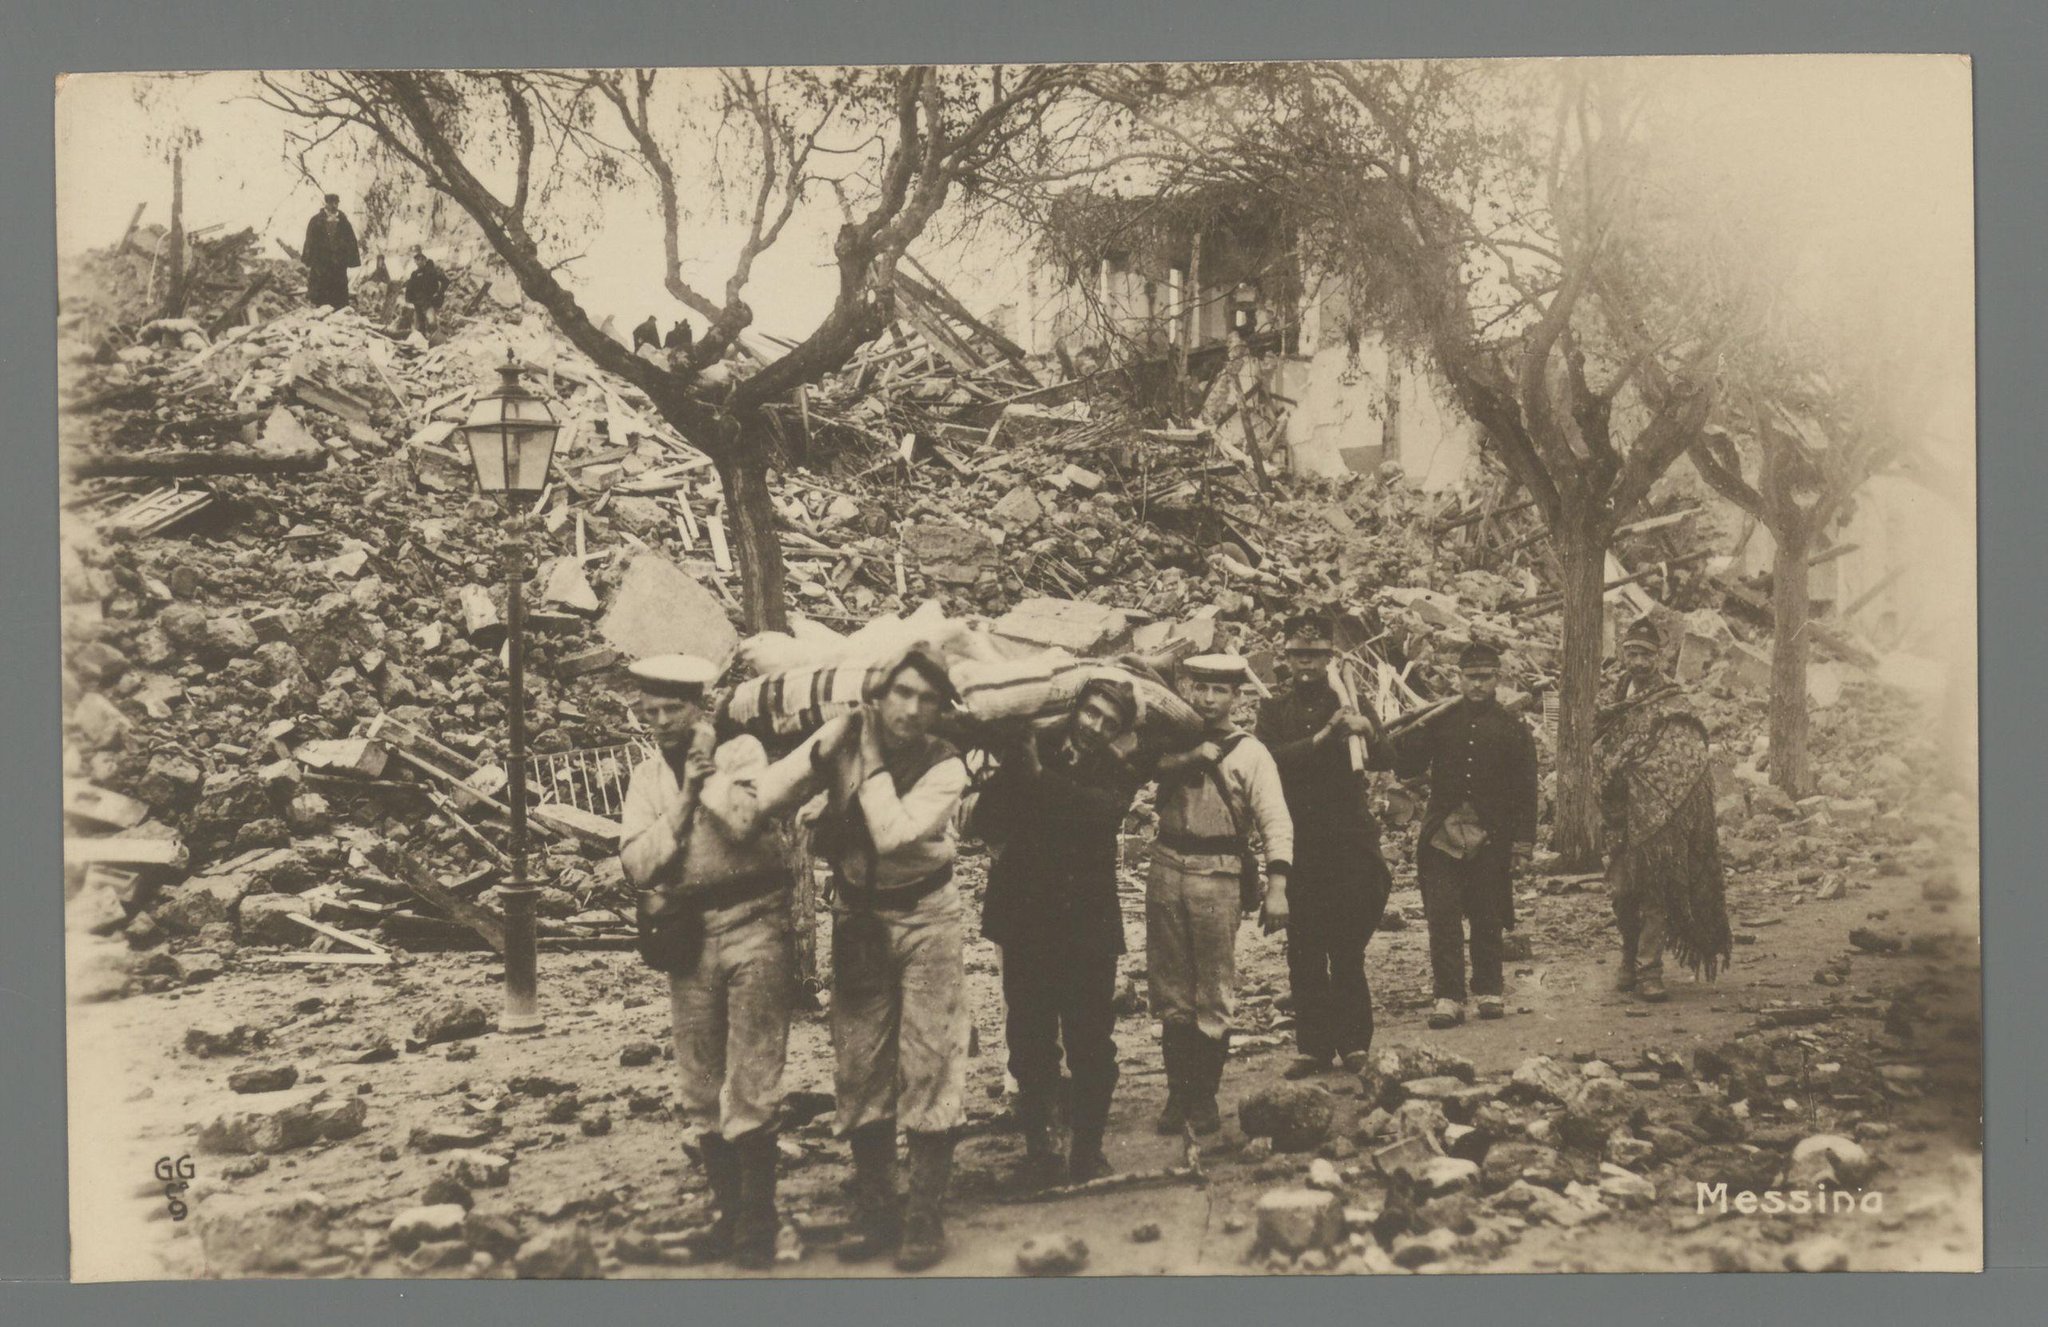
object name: photograph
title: Messina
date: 1908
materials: paper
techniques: gelatin silver print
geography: messina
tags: adult man (+ more than eight persons), consequences of an earthquake, ruin of a dwelling, house, castle, etc.